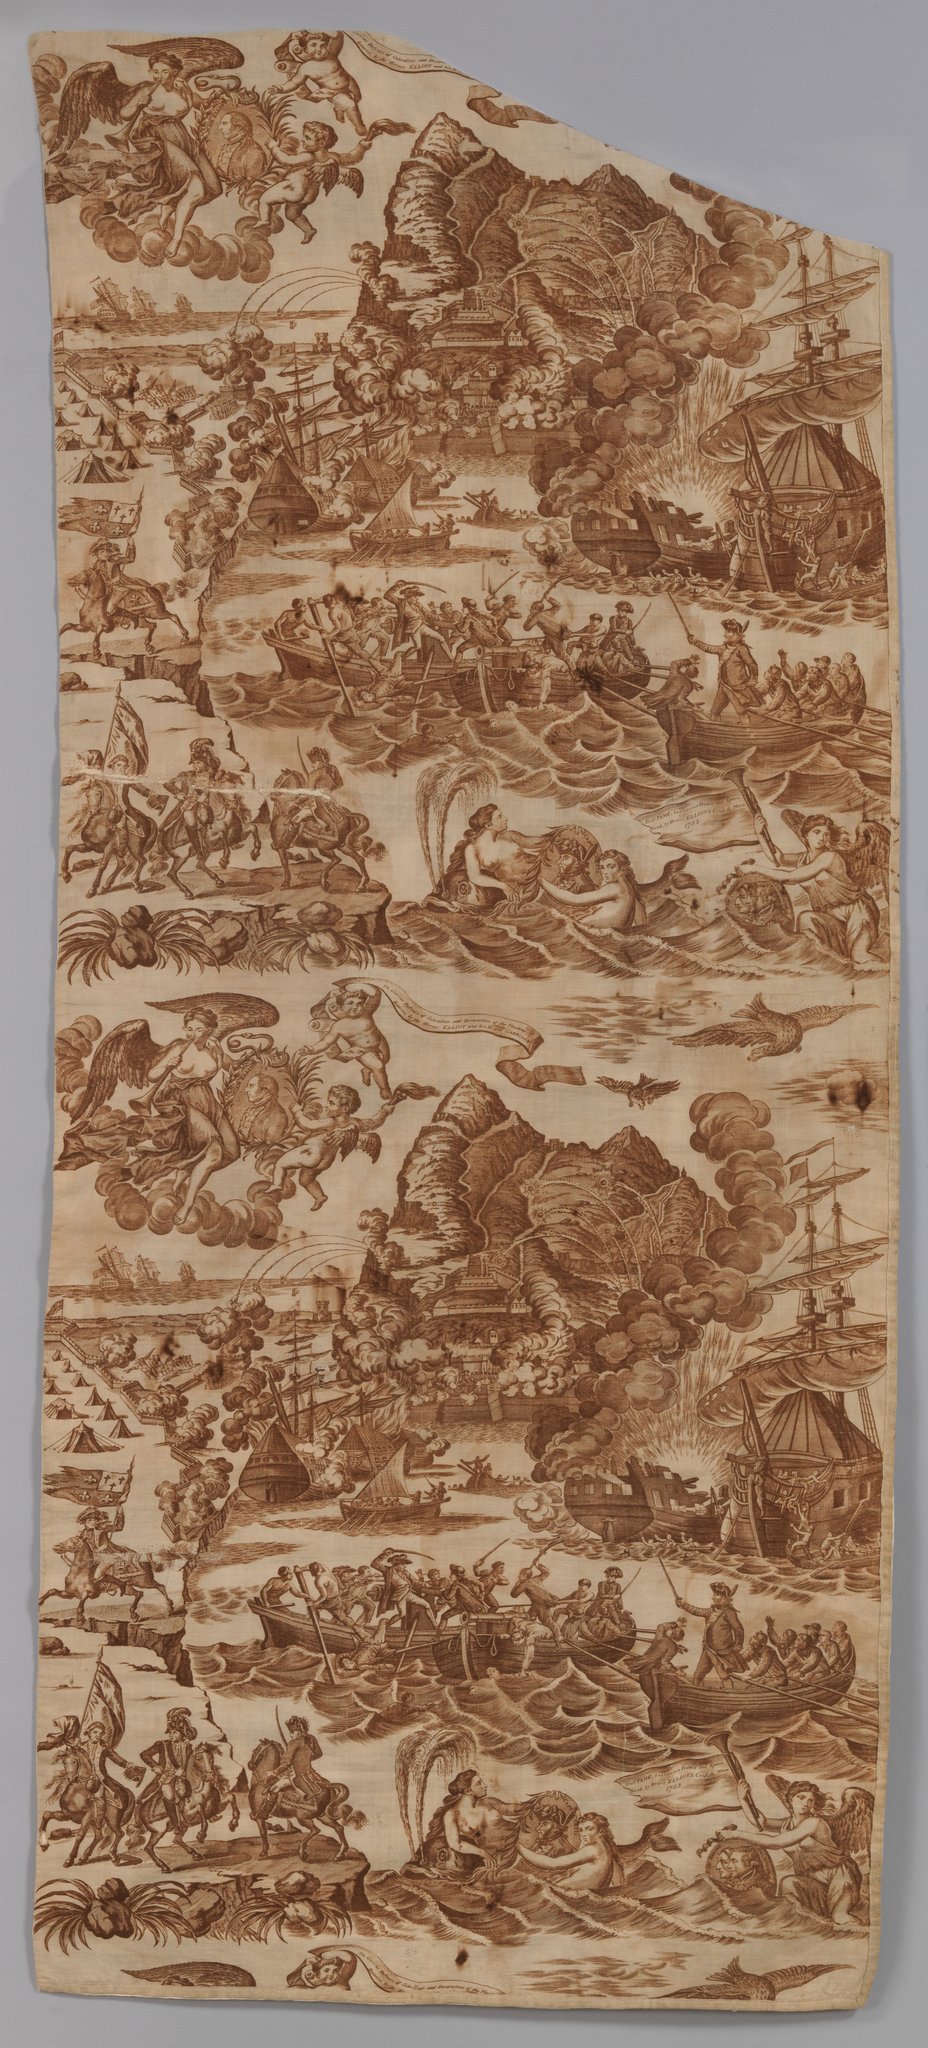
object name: furnishing textile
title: Pictorial print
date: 1785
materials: cotton, linen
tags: battles,soldiers,horses,boats,ships